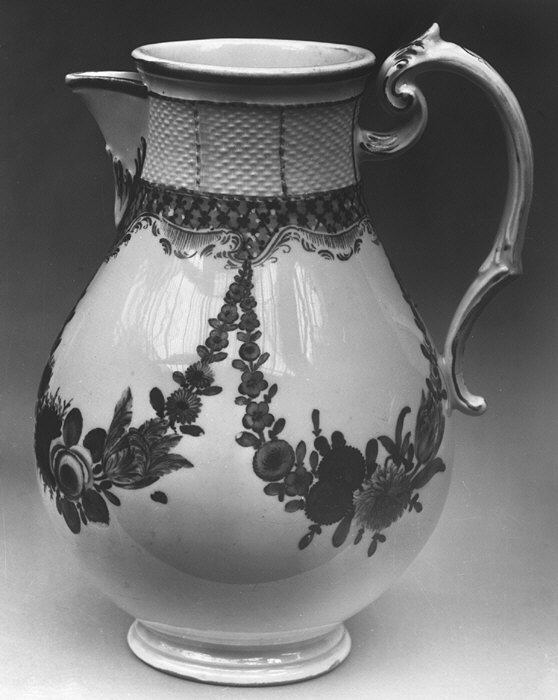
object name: coffeepot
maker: würzburg porcelain manufactory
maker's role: manufactory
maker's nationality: german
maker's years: 1770-1785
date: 1775-1780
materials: hard paste porcelain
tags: flowers